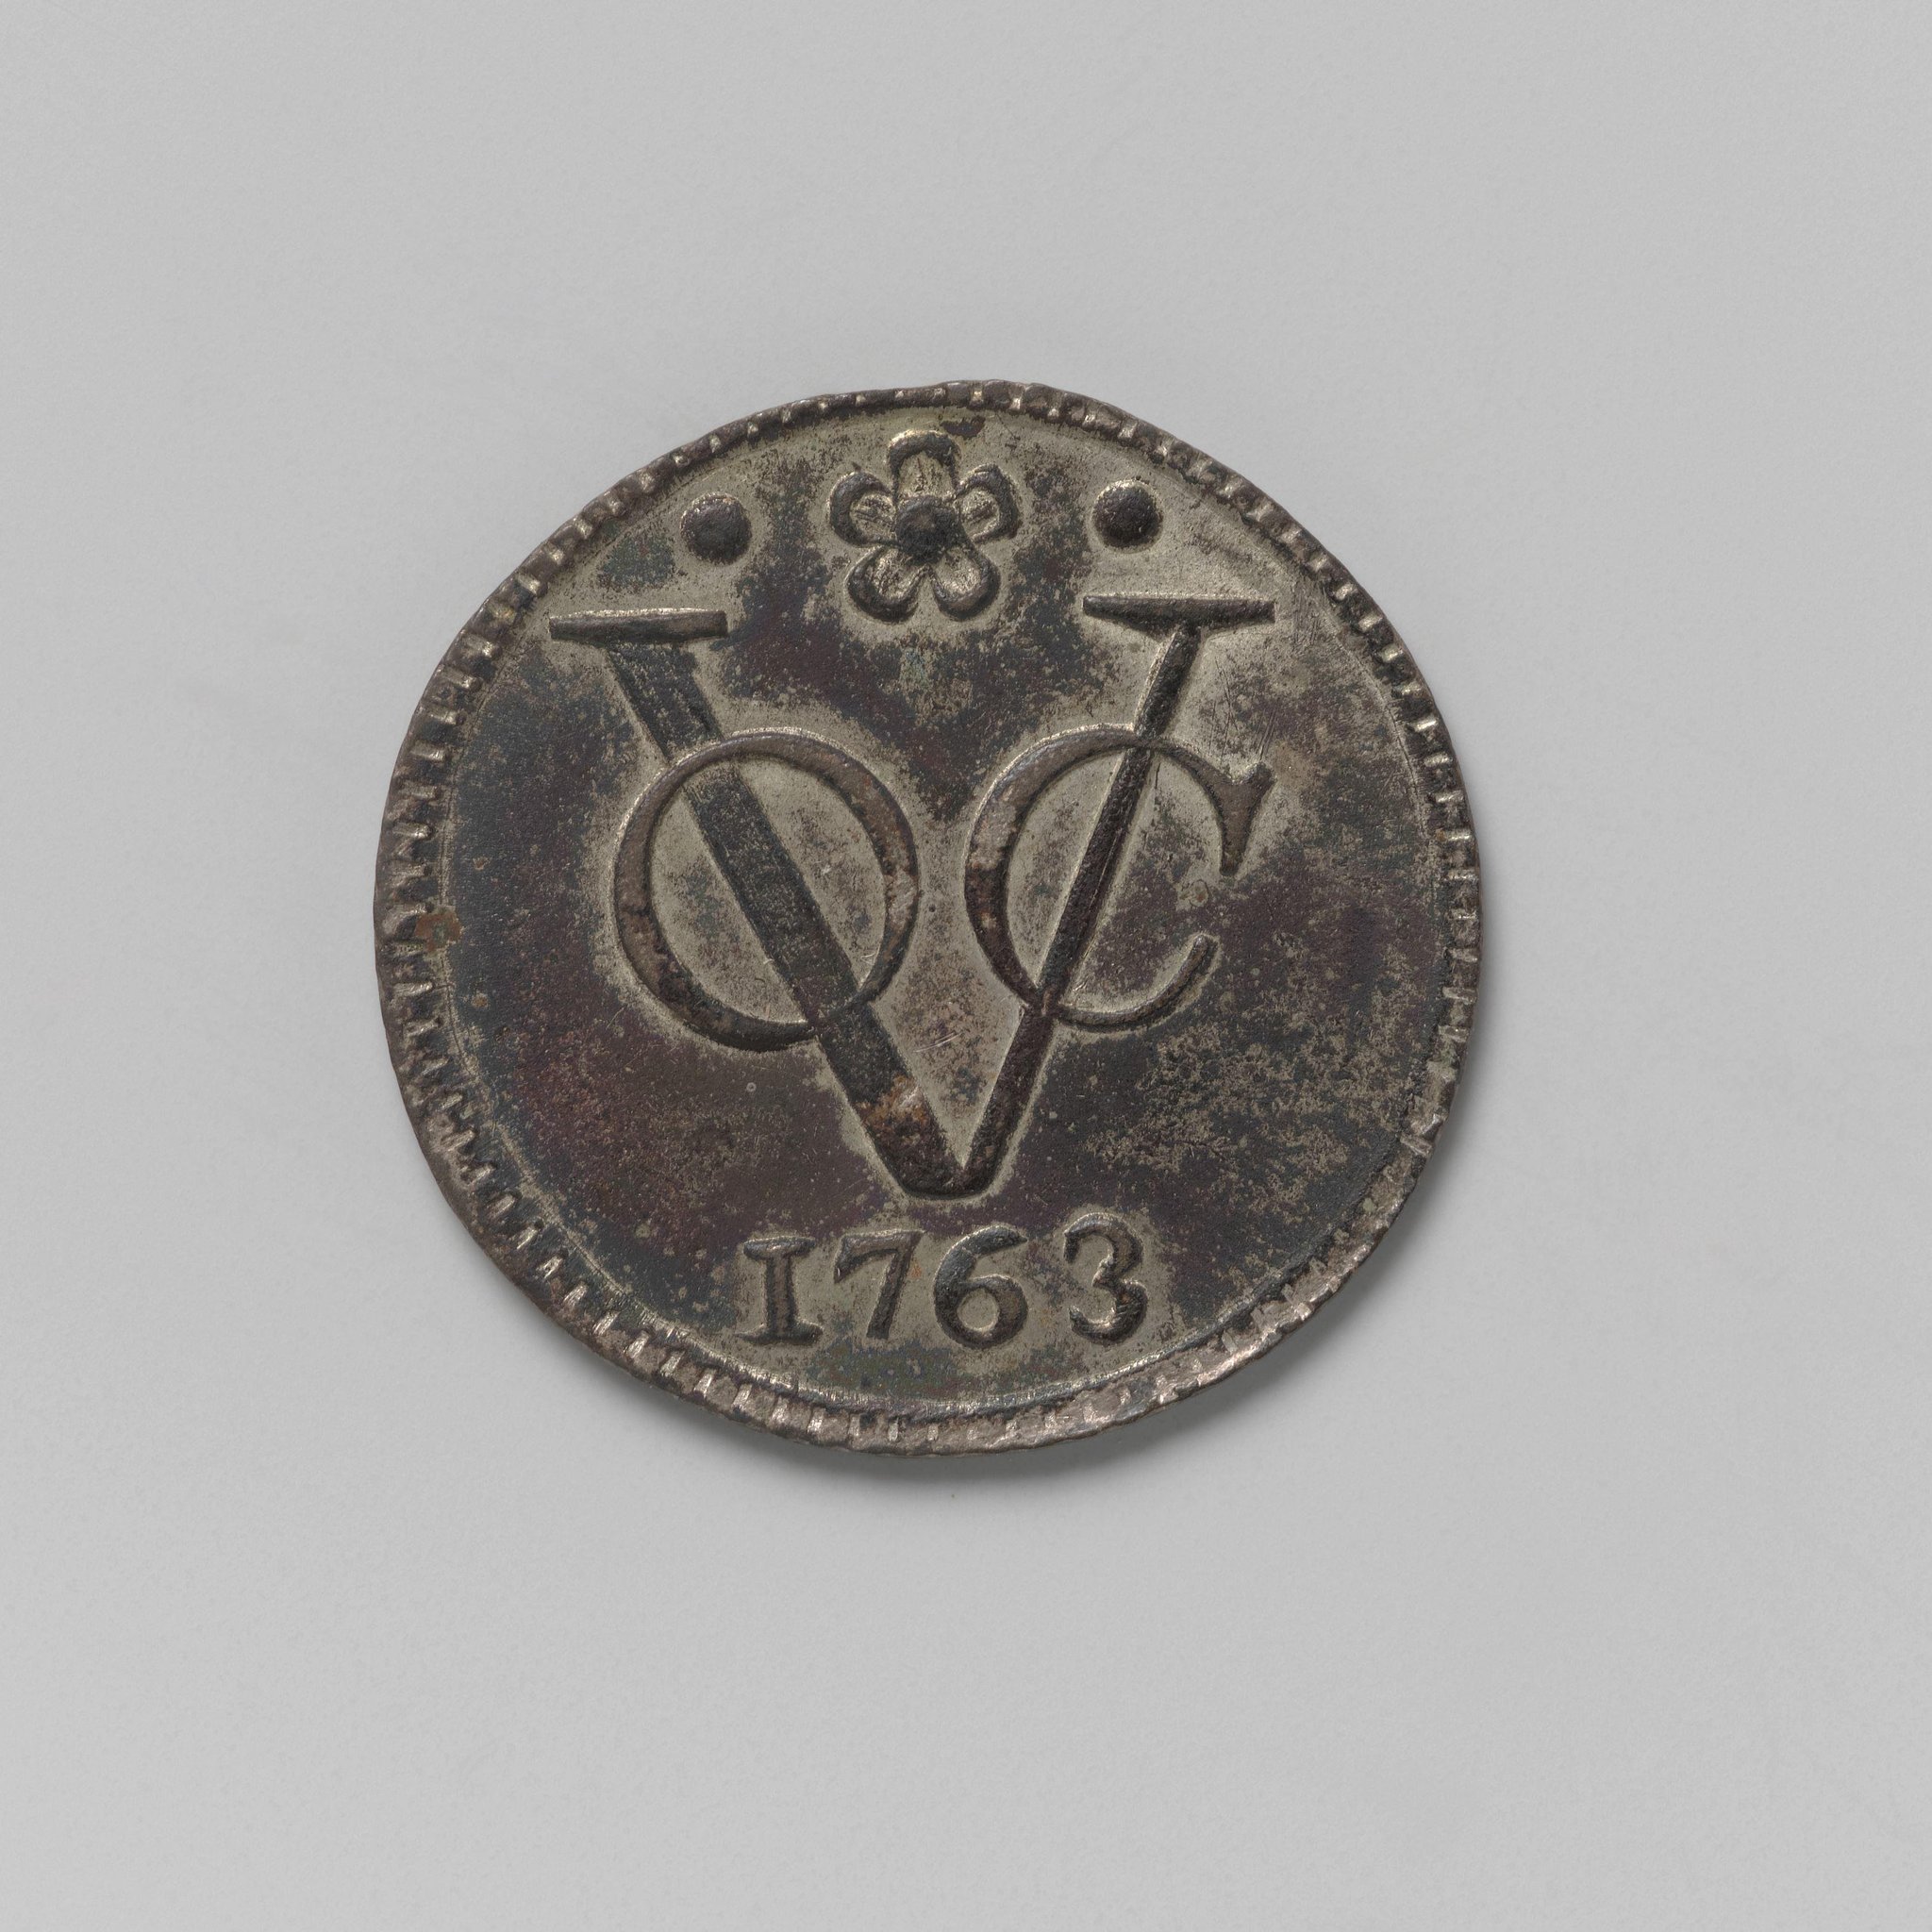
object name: coin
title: VOC, ½ duit Holland, 1763. Afslag in zilver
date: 1763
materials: silver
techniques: striking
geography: dordrecht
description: Zilveren munt. Voorzijde: gekroond wapenschild van Holland. Keerzijde: monogram van de VOC, waarboven muntteken en waaronder jaartal. Kabelrand.